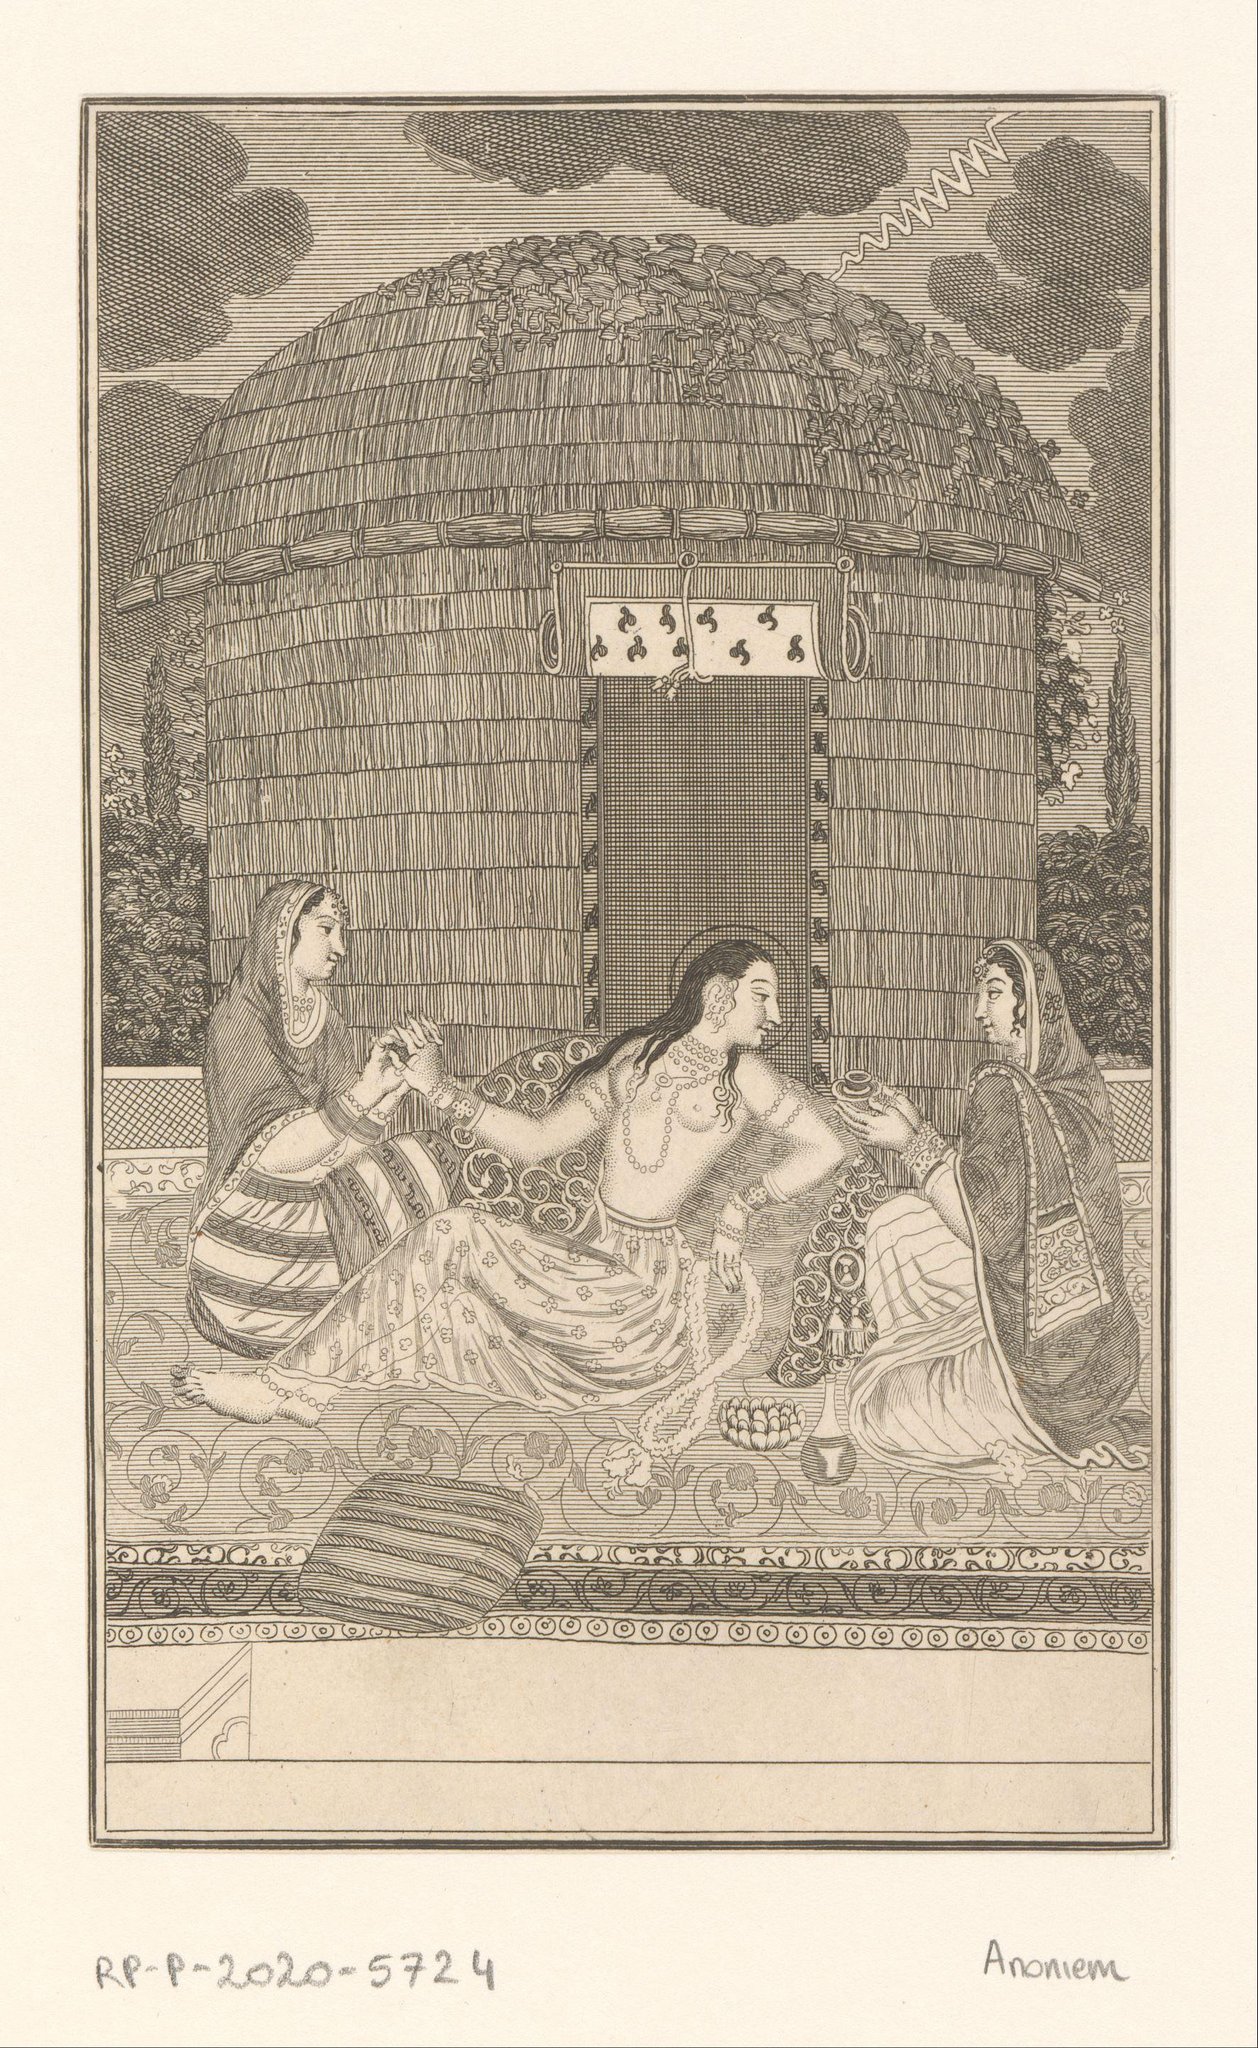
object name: print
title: Indiase vrouw met twee vrouwelijke dienaren voor een hut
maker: Anonymous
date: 1750-1800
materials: paper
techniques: engraving, etching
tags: giving drink, hut, cabin, lodge, asiatic races and peoples: indians, house personnel, servants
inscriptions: number: ‘1’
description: Vermoedelijk gemaakt naar een Indiase miniatuur.